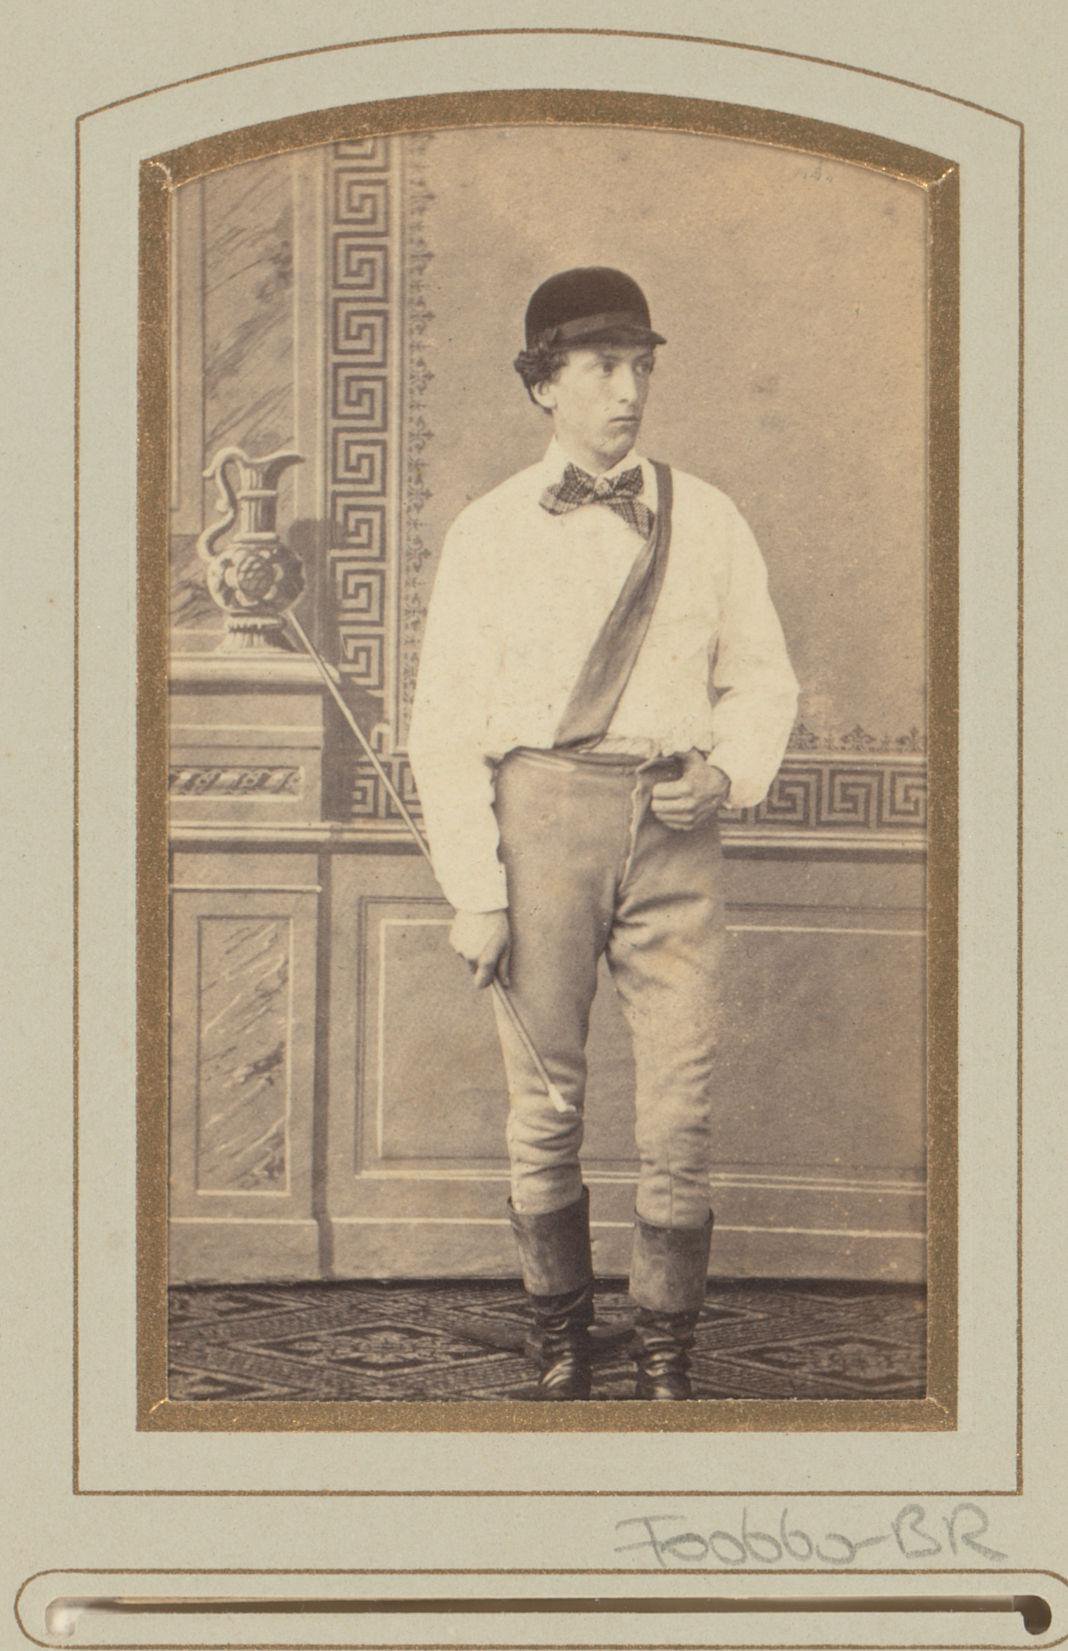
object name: photograph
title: Portret van een jonge man met cap, zweep, vlinderdas en sjerp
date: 1855-1870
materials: cardboard, photographic support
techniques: albumen print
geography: antwerp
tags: riding a horse, ass, or mule; rider, horseman, historical persons, youth, adolescent, whip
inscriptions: inscription: ‘DELEHAYE & SLUYTS,/ PHOTOGRAPHES/ de S.A.R.M.le Duc de Brabant/ Place de Meir, 27,/ ANVERS.’